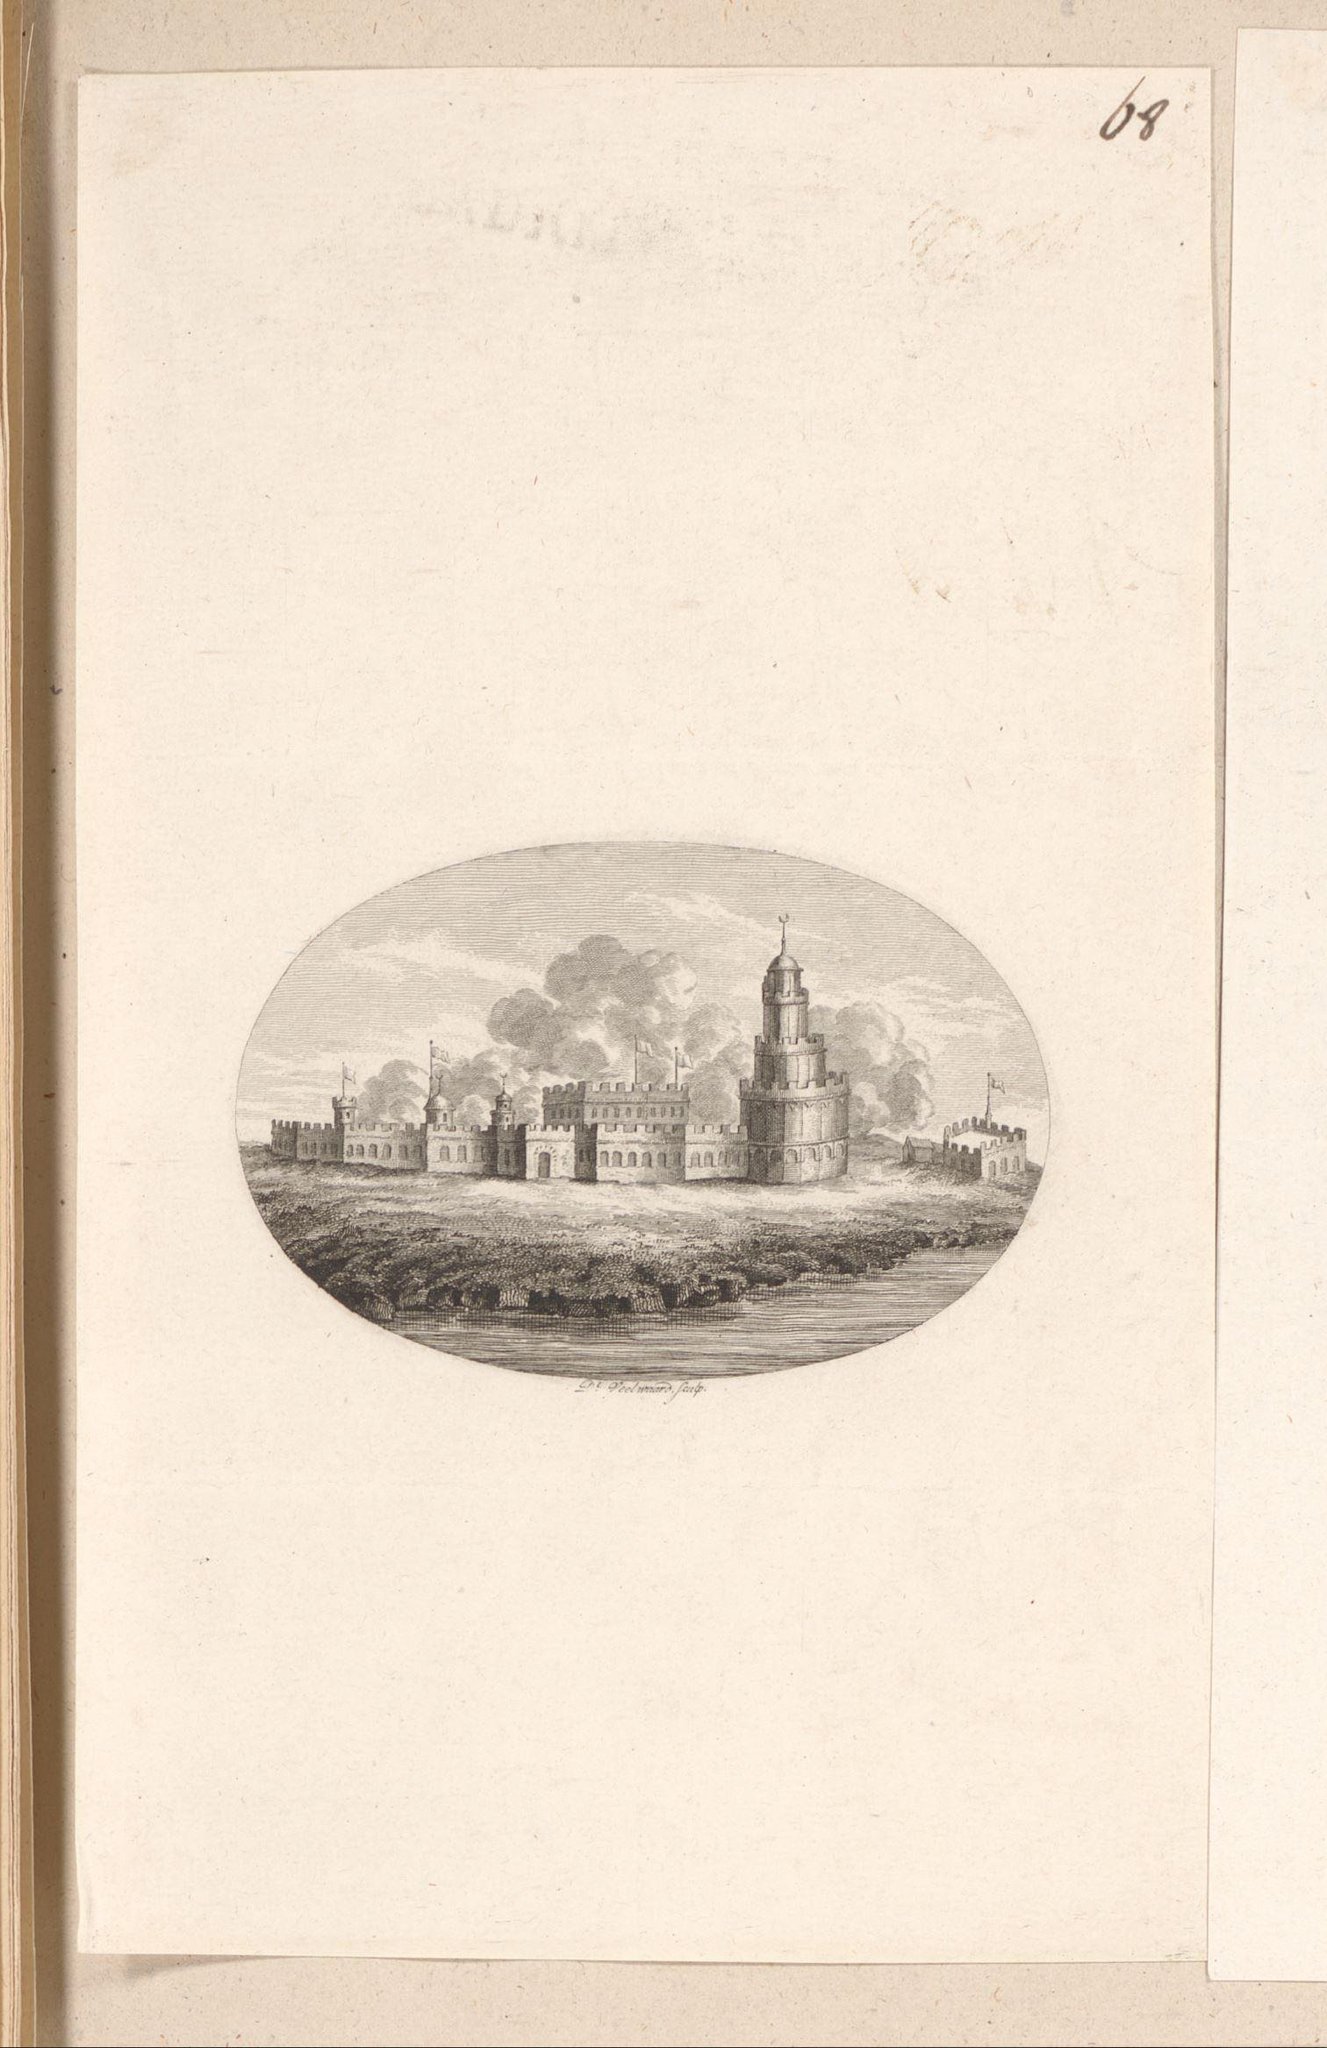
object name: titelblad, titelpagina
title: Gezicht op de vestingwerken van Algiers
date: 1817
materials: paper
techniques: engraving, etching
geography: amsterdam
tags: commander-in-chief, admiral (+ naval force), title-page, permanent fortifications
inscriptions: inscription: ‘68’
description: Proefdruk van een titelpagina gebruikt voor: Adriaan Pieterz. Loosjes, Lauwerkroon voor de Nederlandsche zeehelden bij hunne betoonde moed en dapperheid in den zeeslag voor Algiers, den 28sten van Oogstmaand 1816. Haarlem: A. Loosjes, 1817.